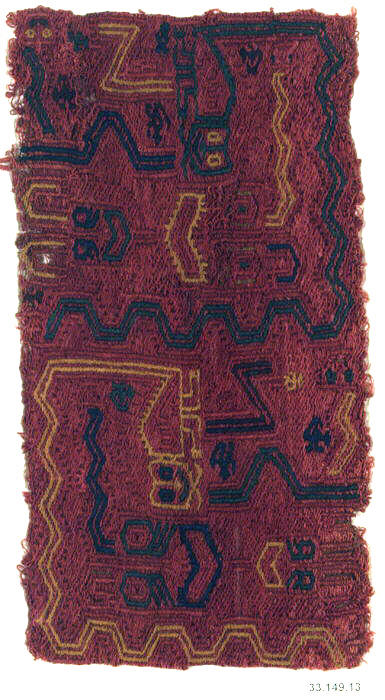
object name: textile fragment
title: Embroidered Fragment with Figures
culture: paracas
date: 500-101 BCE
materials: animal fiber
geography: peru